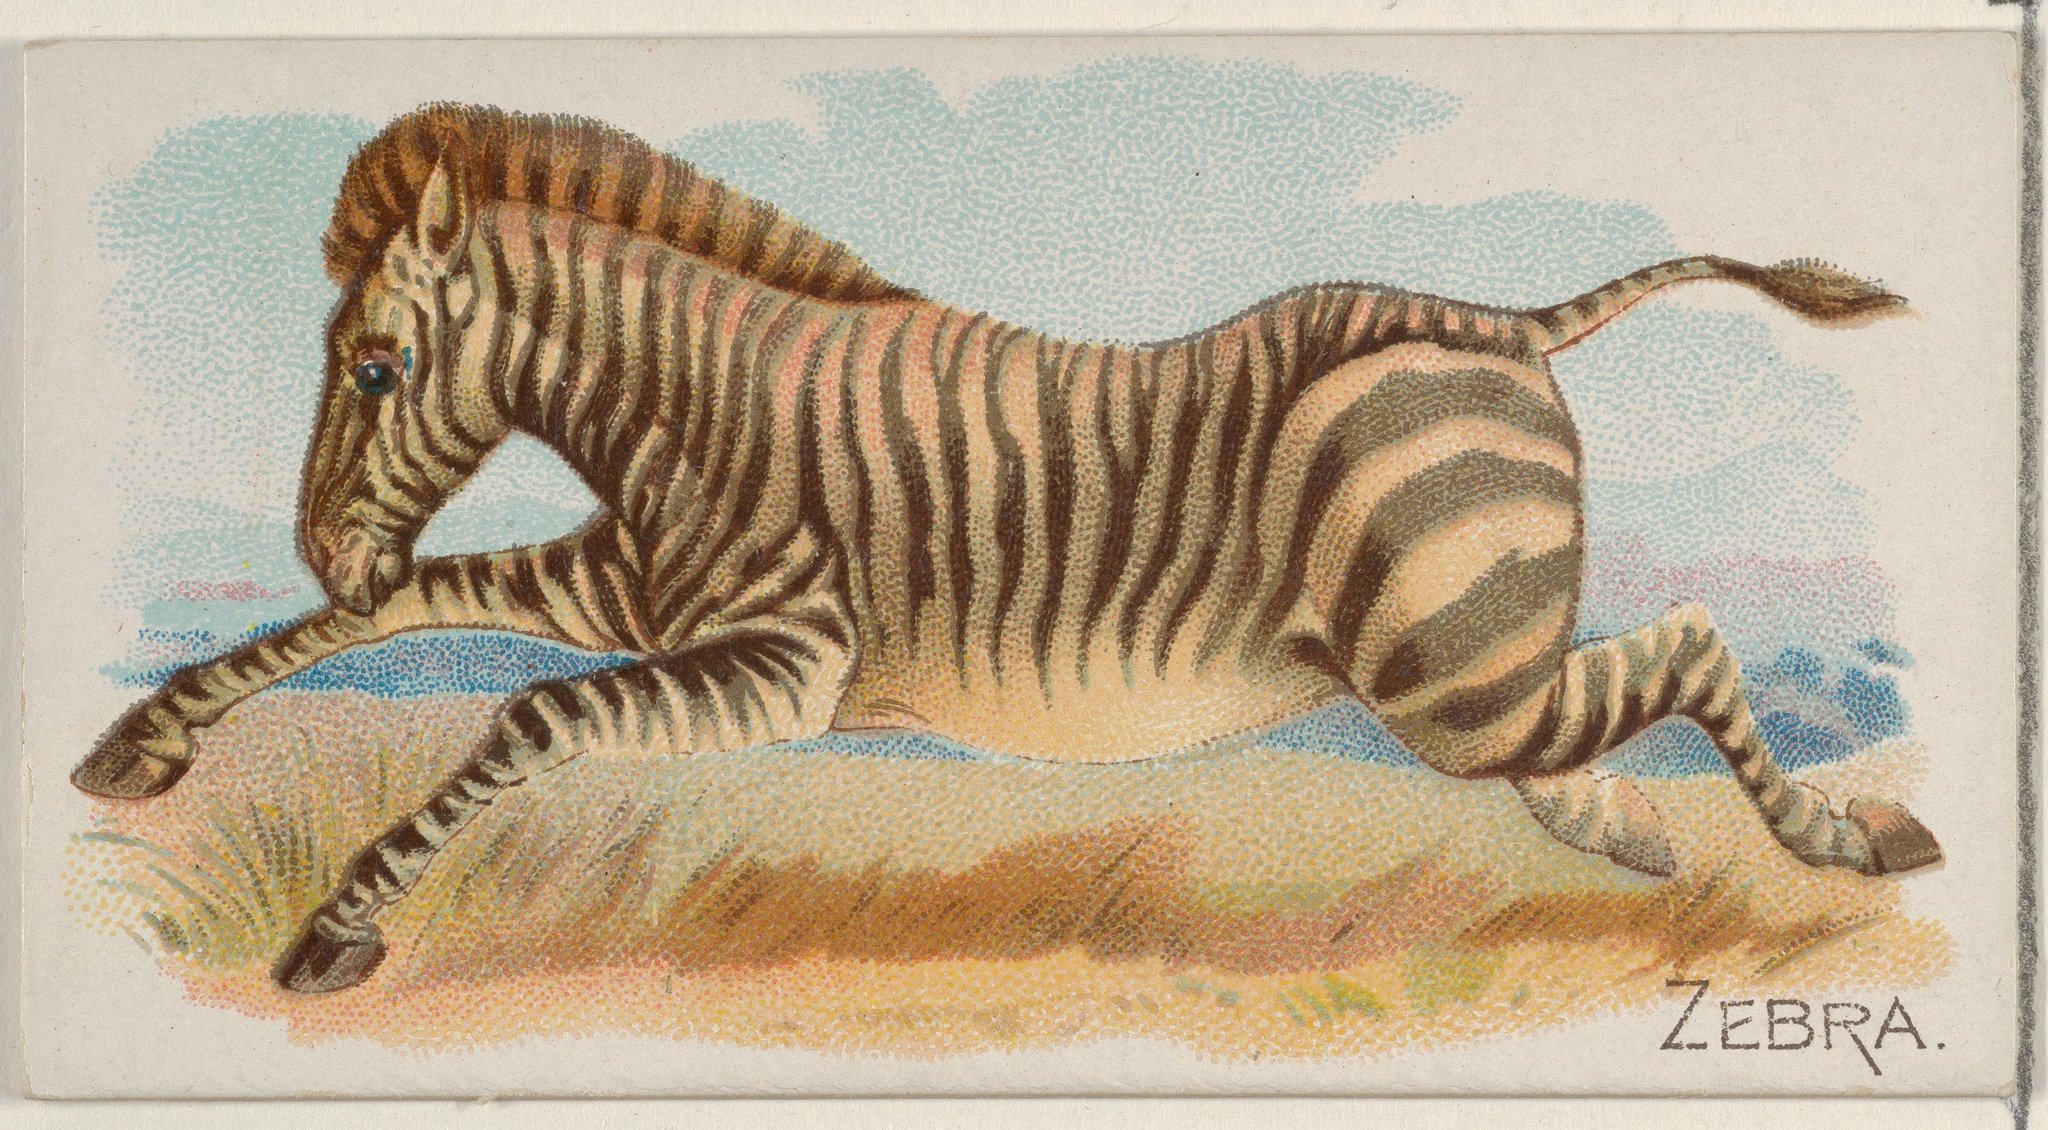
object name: print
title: Zebra, from the Quadrupeds series (N21) for Allen & Ginter Cigarettes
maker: allen & ginter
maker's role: publisher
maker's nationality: american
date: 1890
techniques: color lithograph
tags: zebras